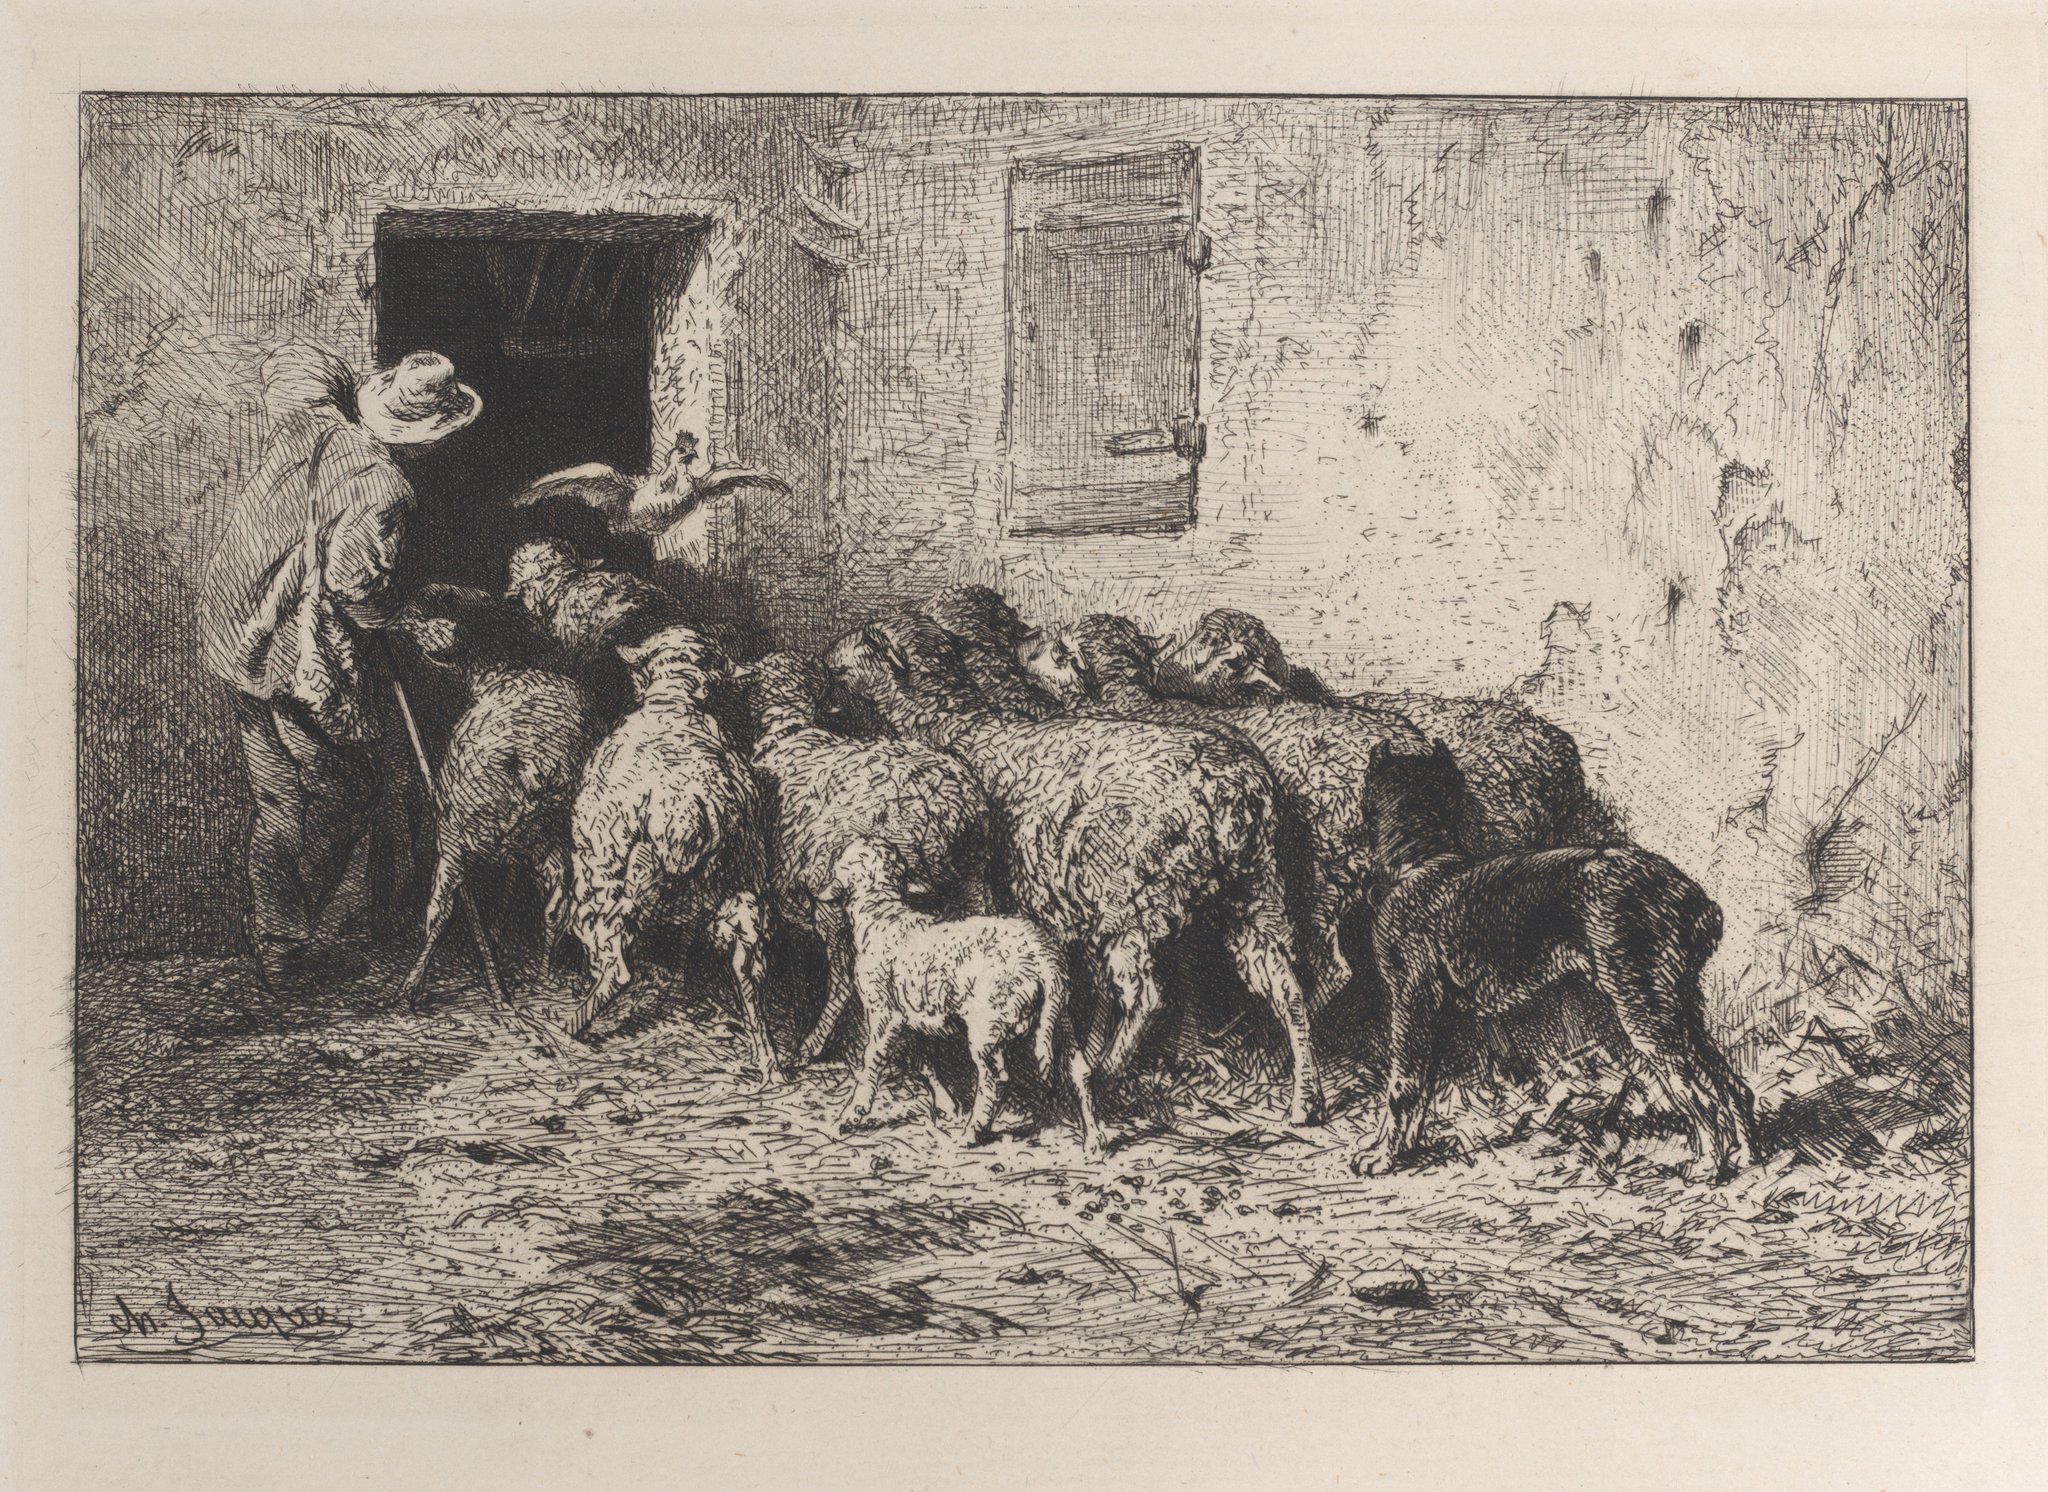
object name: print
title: The Return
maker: charles émile jacque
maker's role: artist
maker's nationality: french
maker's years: 1813-1894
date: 1864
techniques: etching